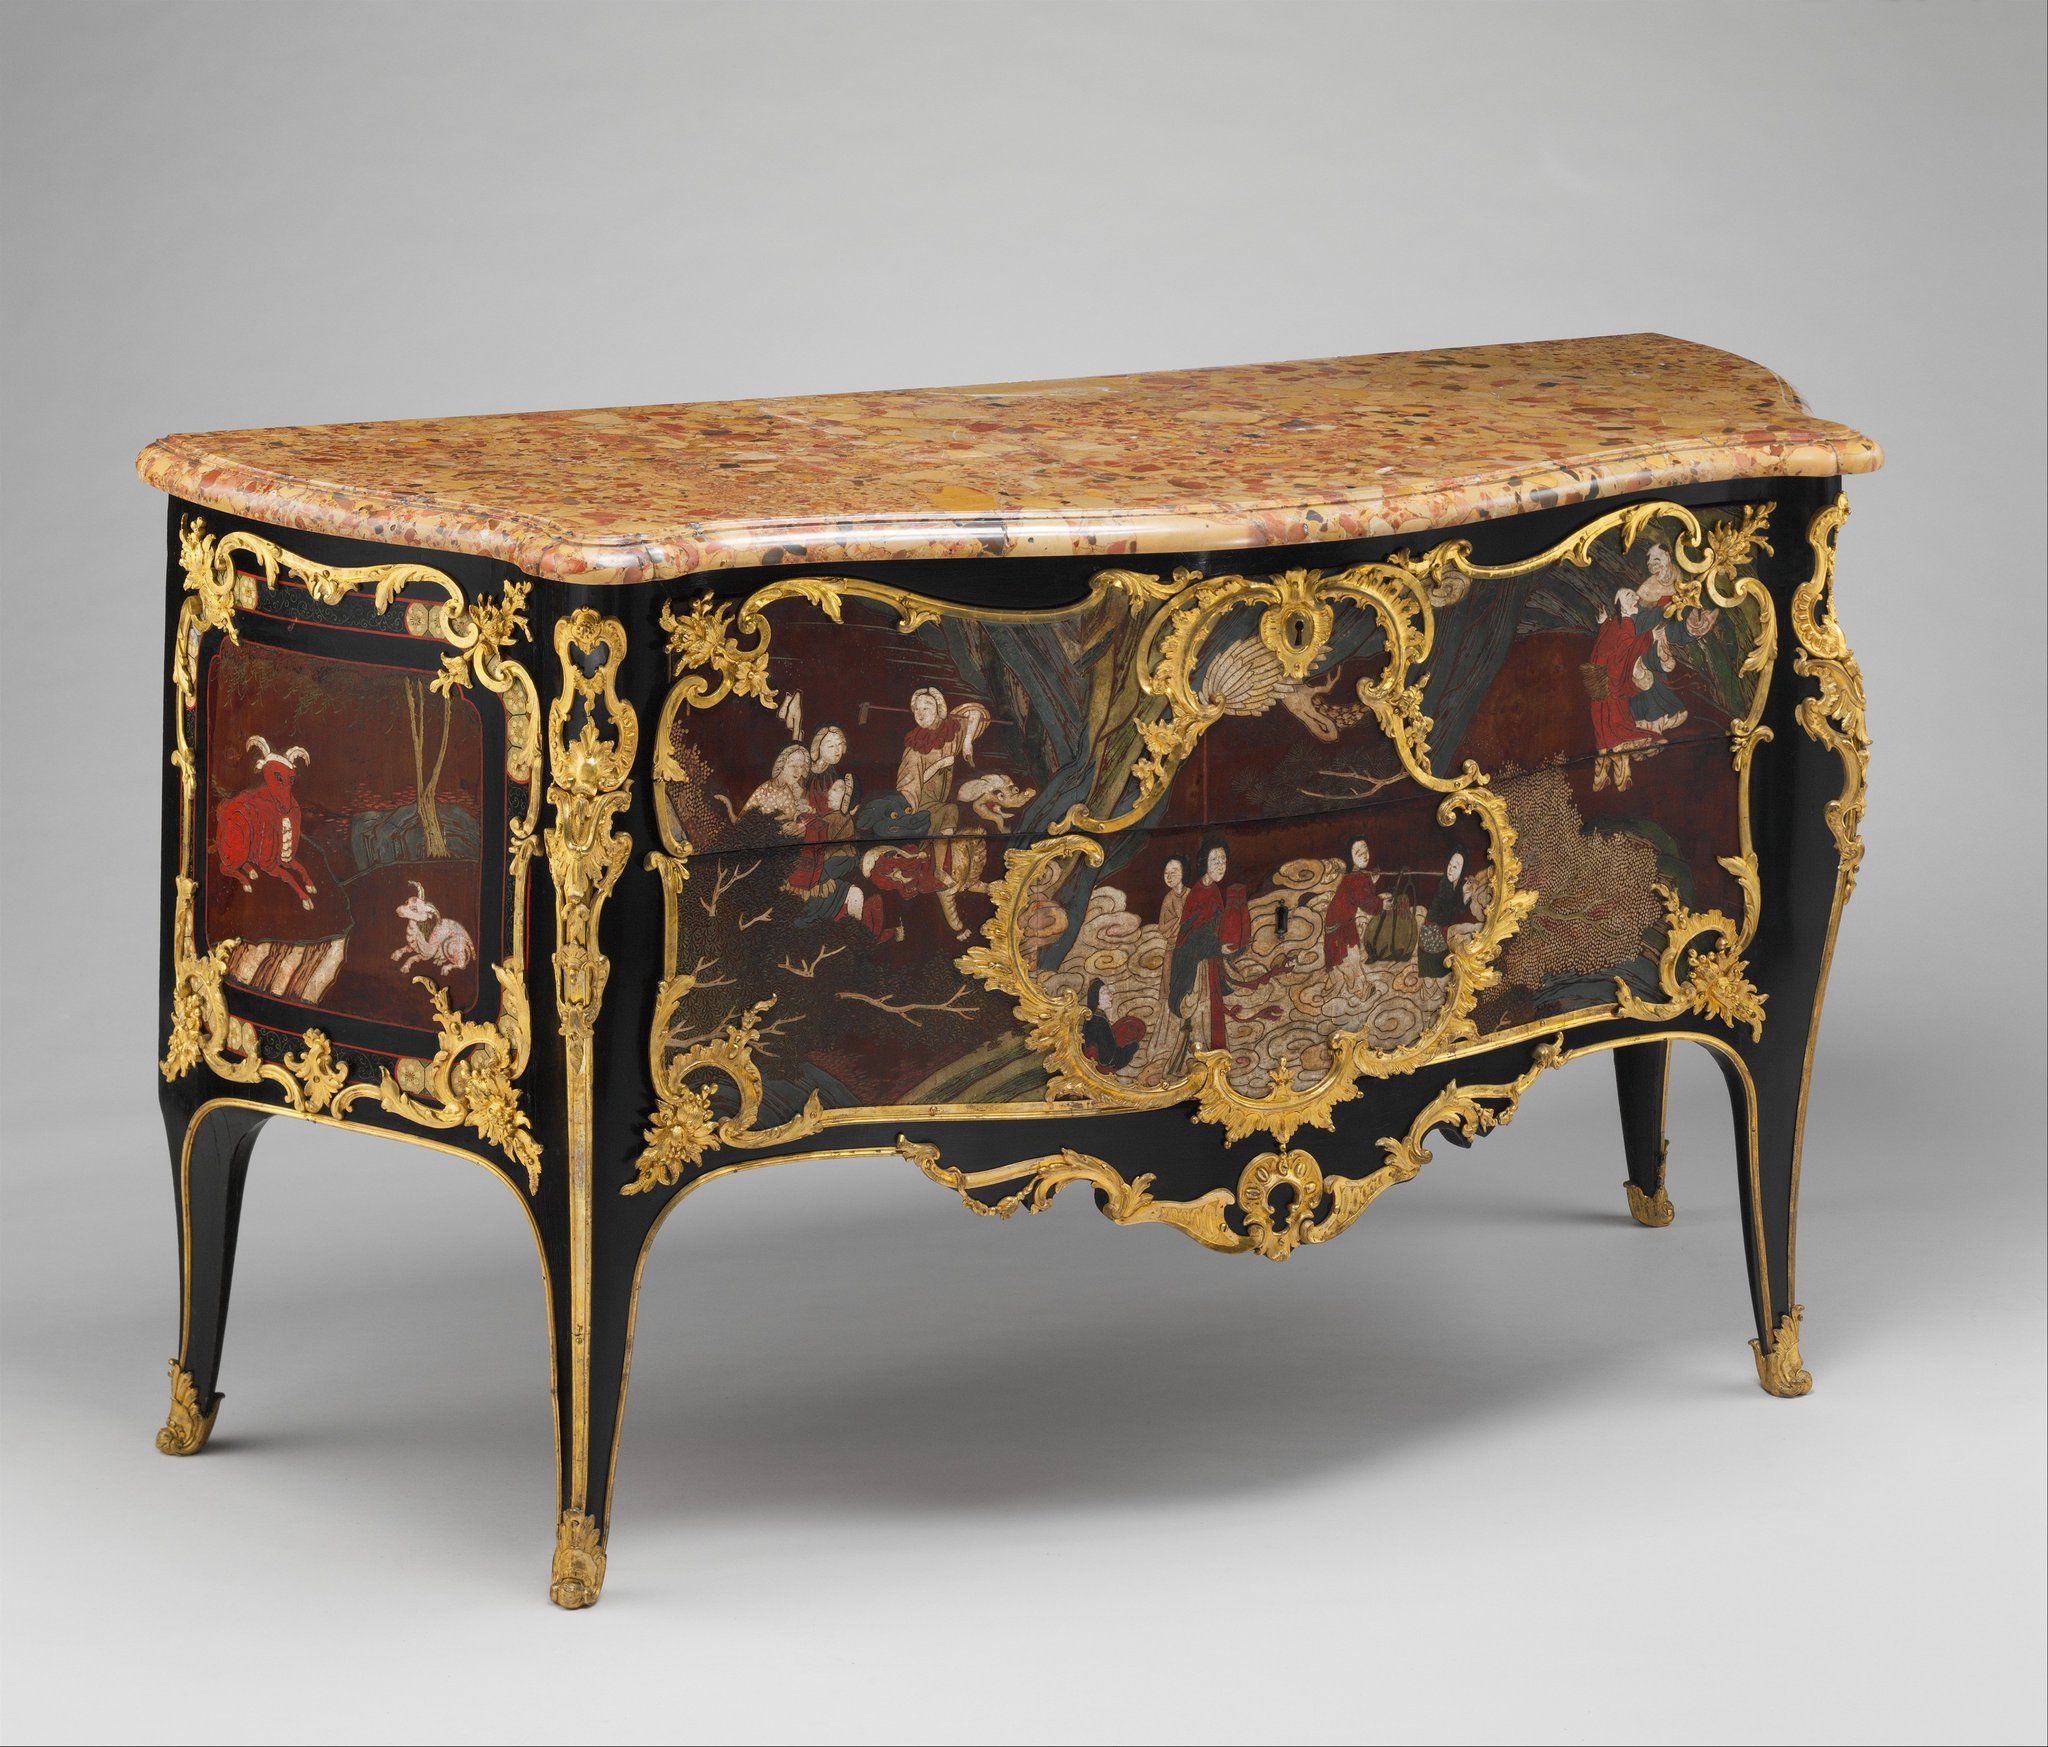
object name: commode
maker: bernard ii van risenburgh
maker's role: maker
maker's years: 1696-1767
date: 1740-1745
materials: gilt bronze, lacquer, marble, wood, panel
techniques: lacquer, veneering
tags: animals,men,women